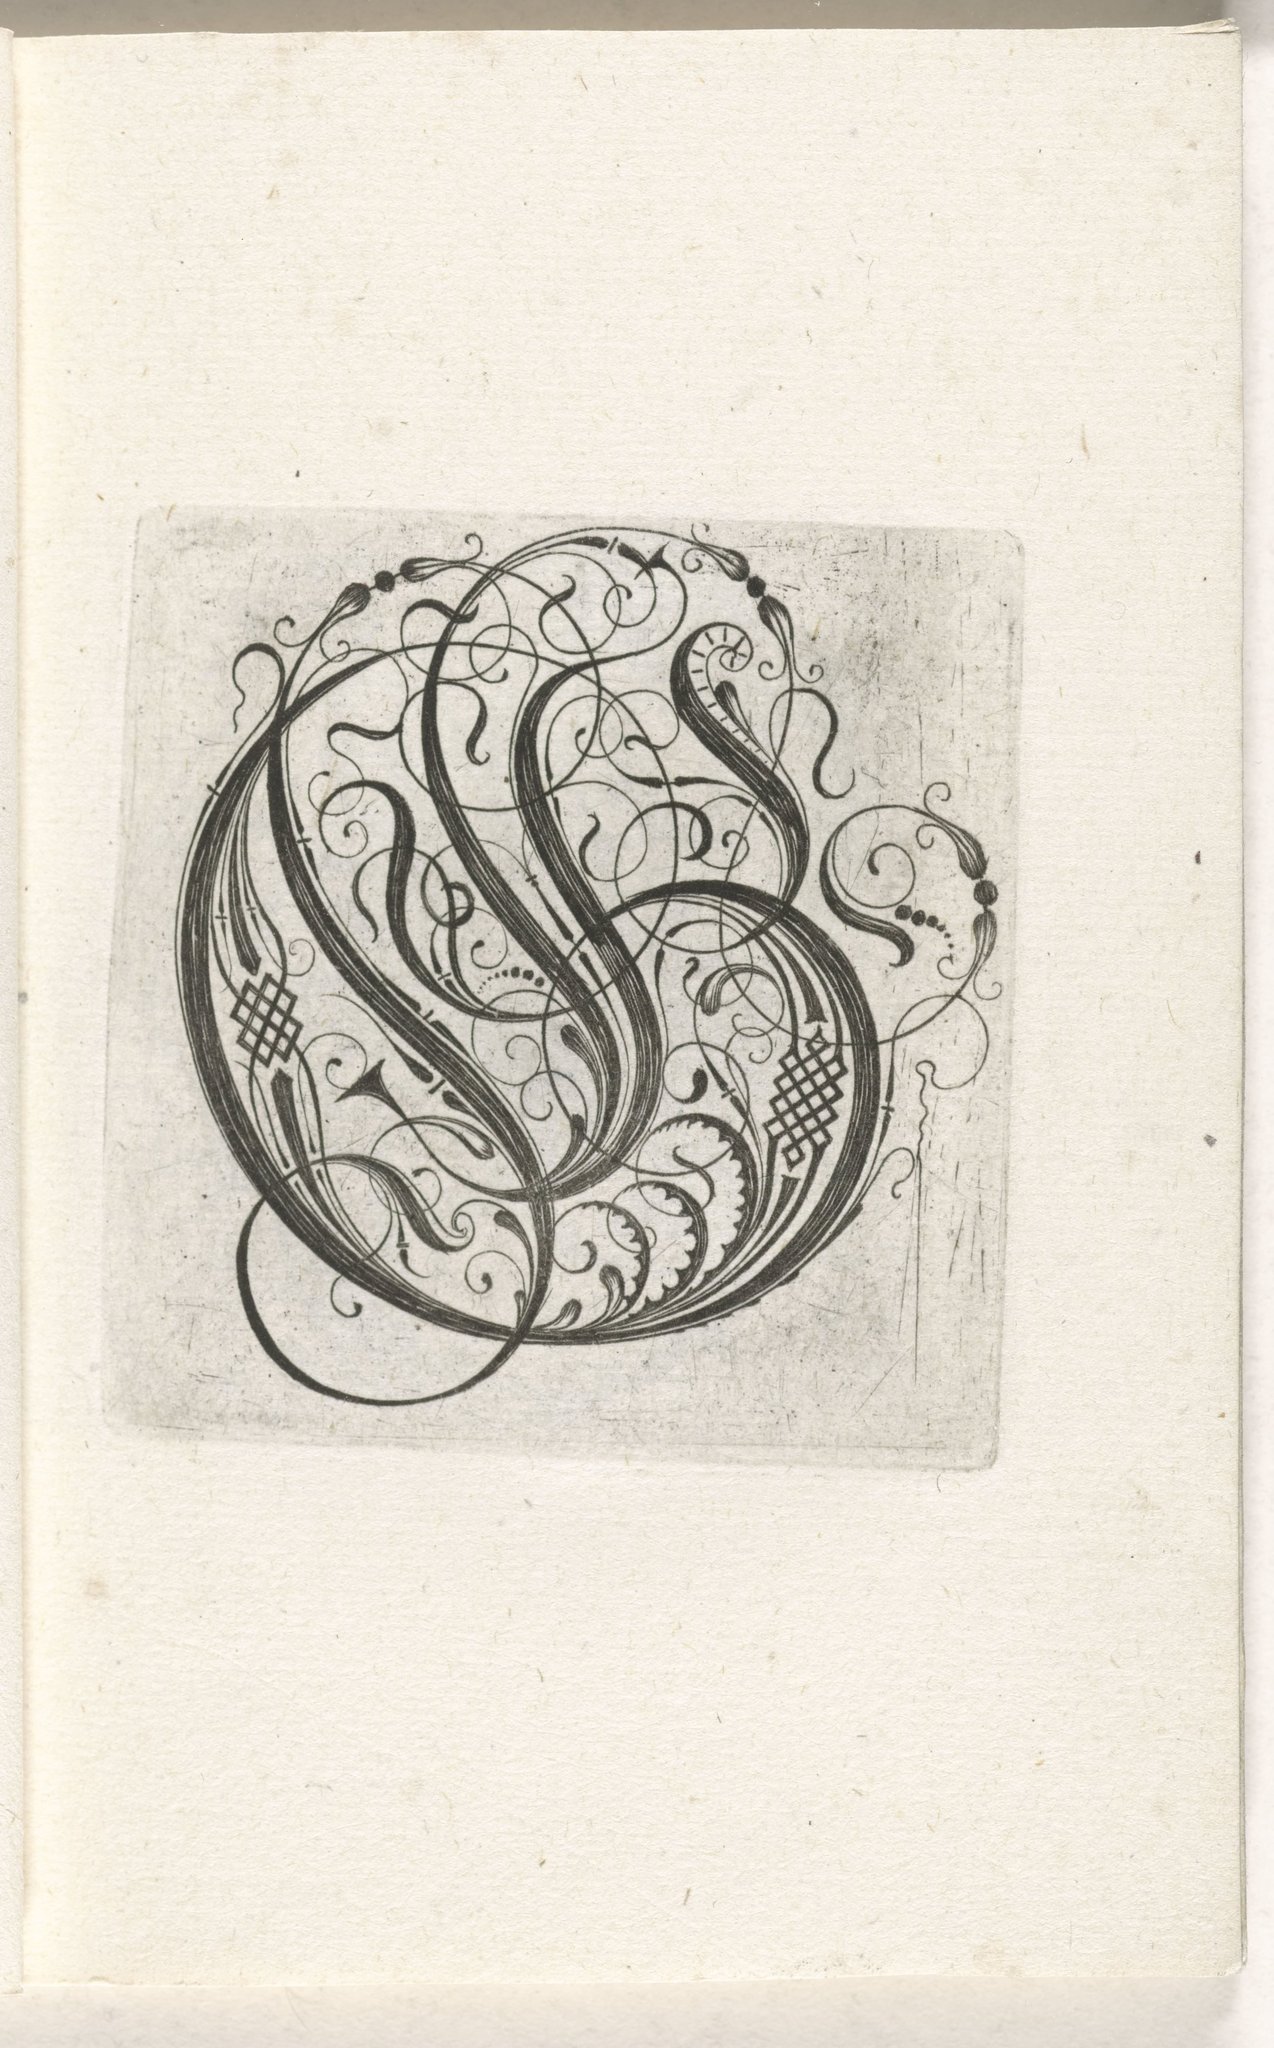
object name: print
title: Alfabet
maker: Anonymous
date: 1600-1699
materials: paper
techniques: engraving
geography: netherlands